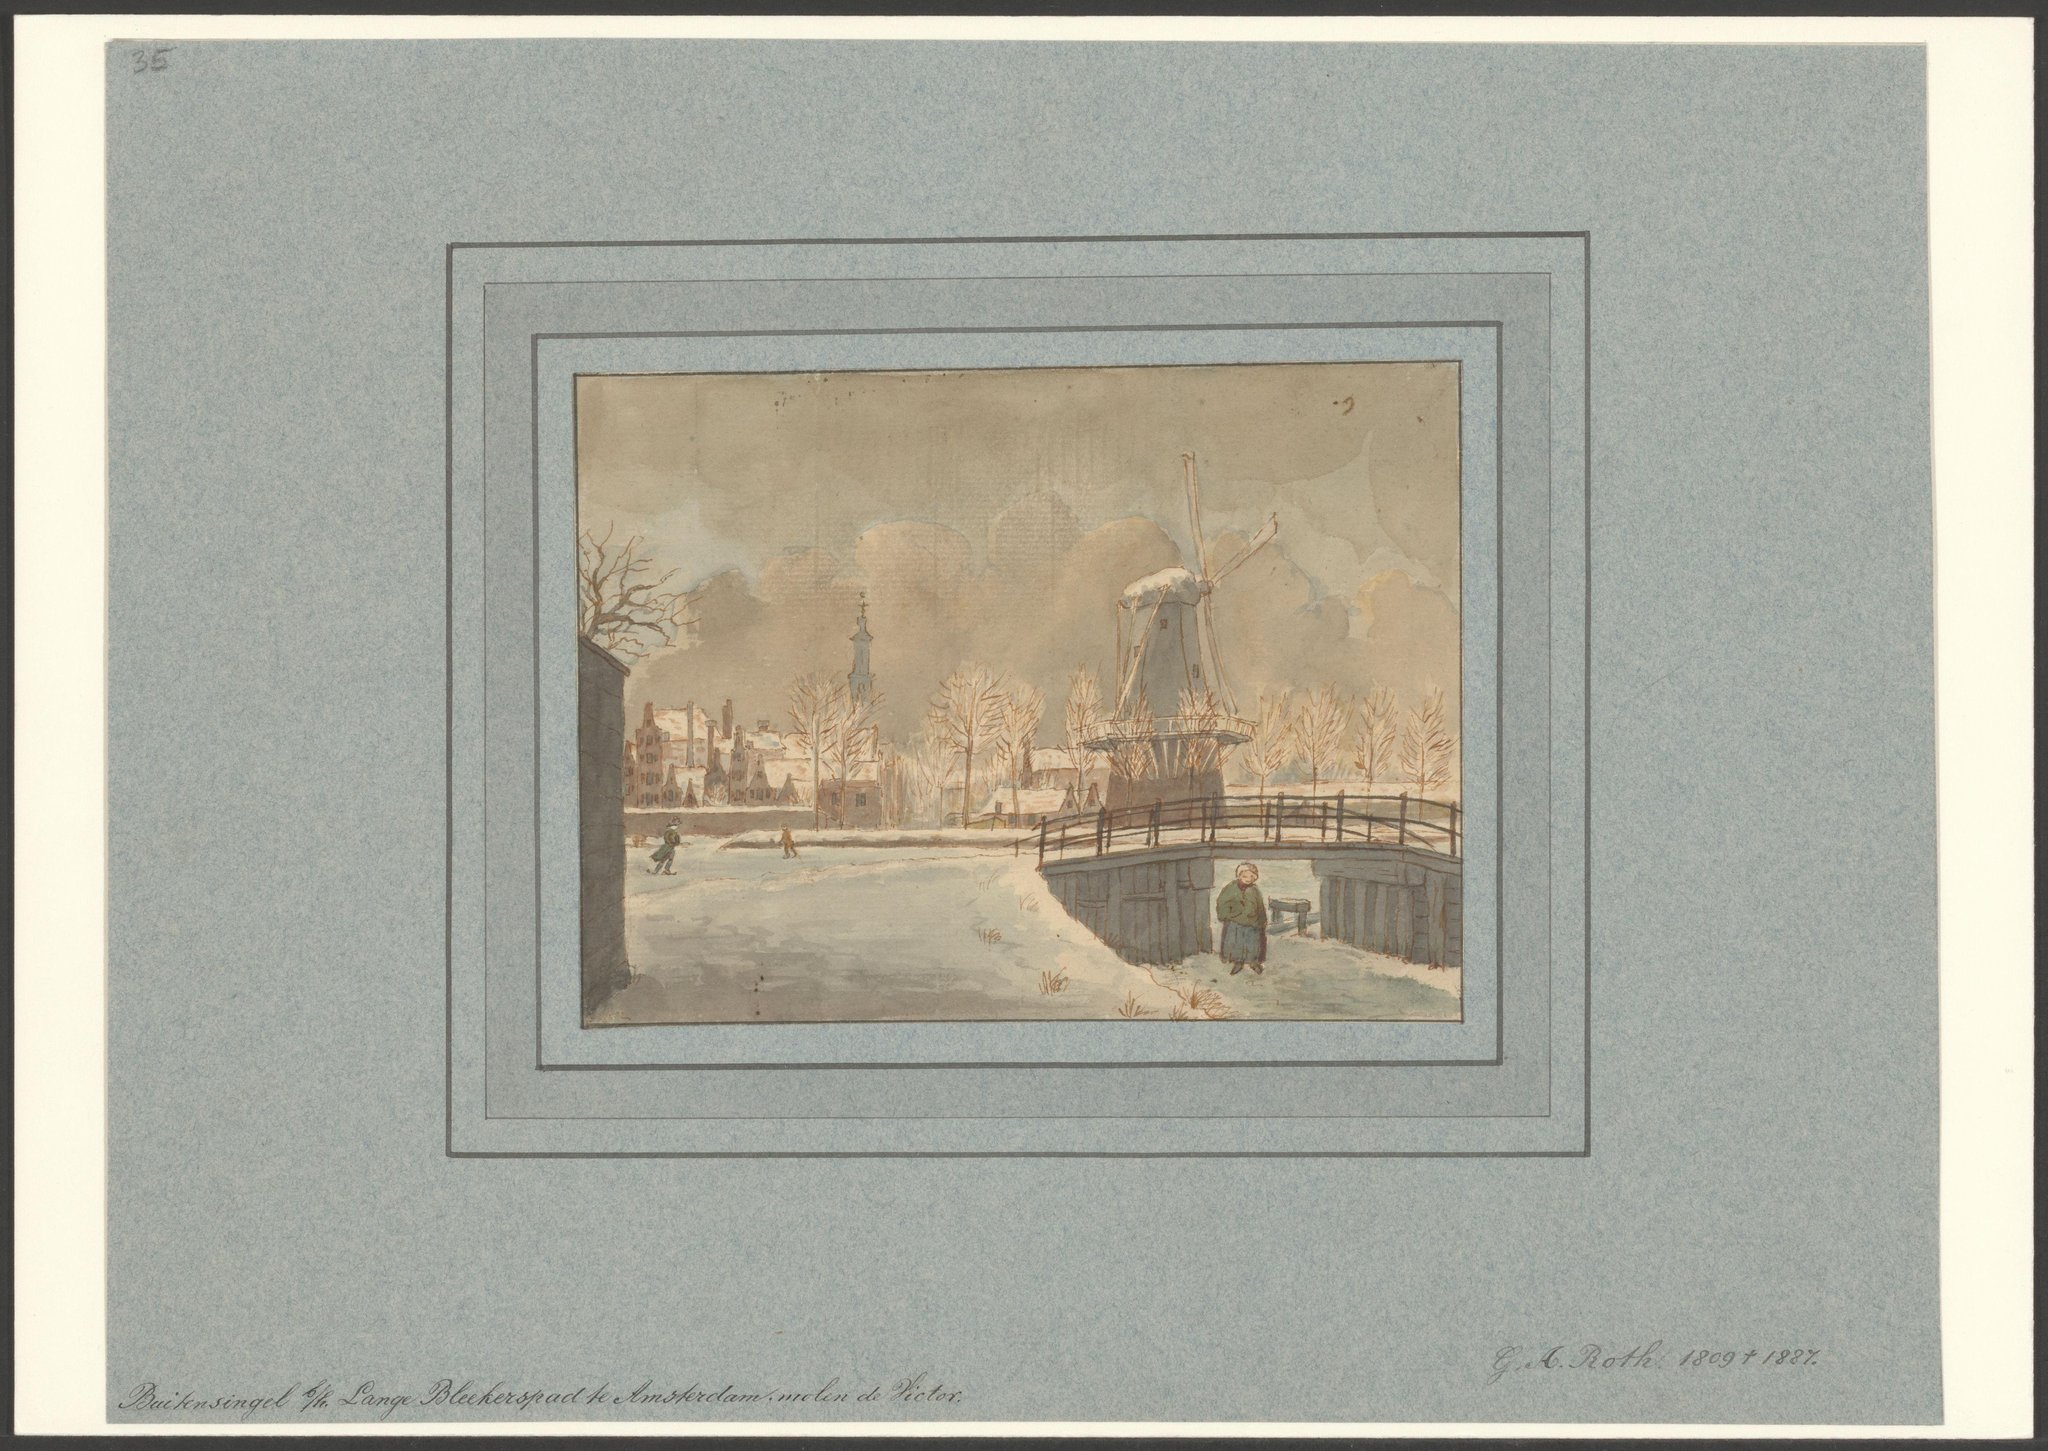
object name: drawing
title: Gezicht op de Buitensingel bij het Lange Blekerspad, gezien naar molen De Victor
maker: george andries roth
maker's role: draughtsman, painter, print maker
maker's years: 1809-1887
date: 1819-1887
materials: ink, paper, watercolor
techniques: brush, pen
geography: amsterdam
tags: city-view in general; 'veduta', canal, windmill in landscape, bridge in city across river, canal, etc.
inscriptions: name: ‘G.A.Roth.1809+1887.’, inscription: ‘Molen de Victor’, inscription: ‘Buitensingel b/h Lange Bleekerspad te Amsterdam. molen de Victor’, number: ‘35’